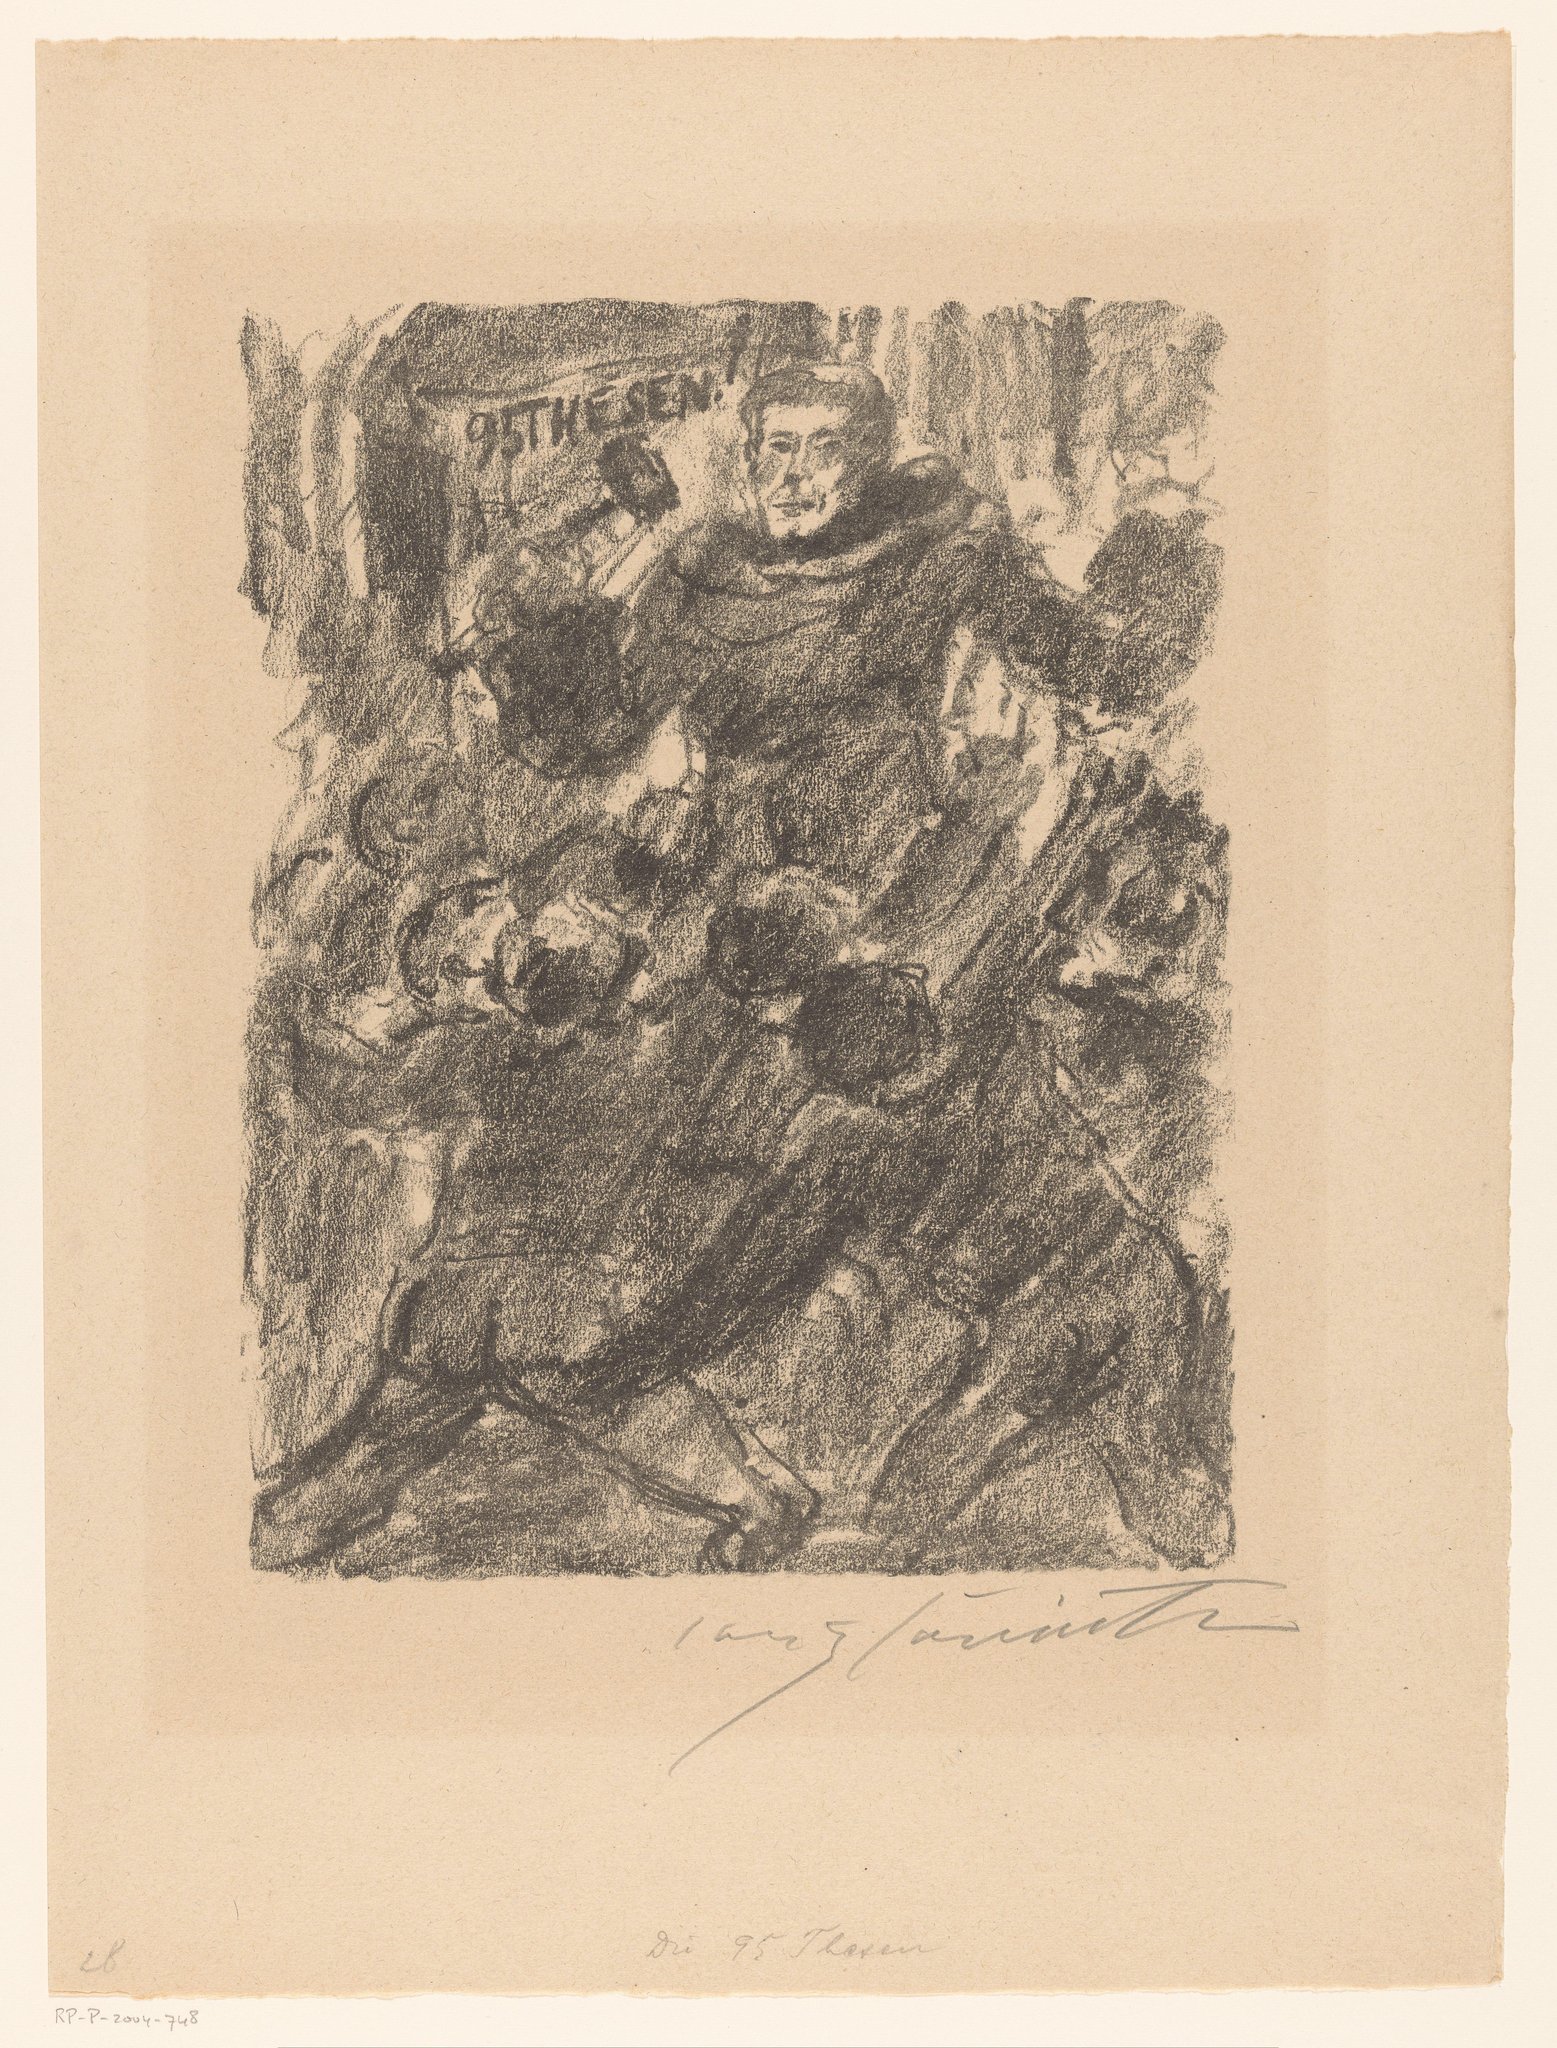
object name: print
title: Die neuen Bilderbücher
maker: lovis corinth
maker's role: print maker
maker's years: 1858-1925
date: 1920-1921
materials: paper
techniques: lithograph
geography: germany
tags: martin luther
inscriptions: collector's mark: Lugt 2228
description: Dit is plaat dertien uit de serie Die neuen Bilderbücher/ Dritte Folge/ Martin Luther/ Originallithographien von Lovis Corinth.